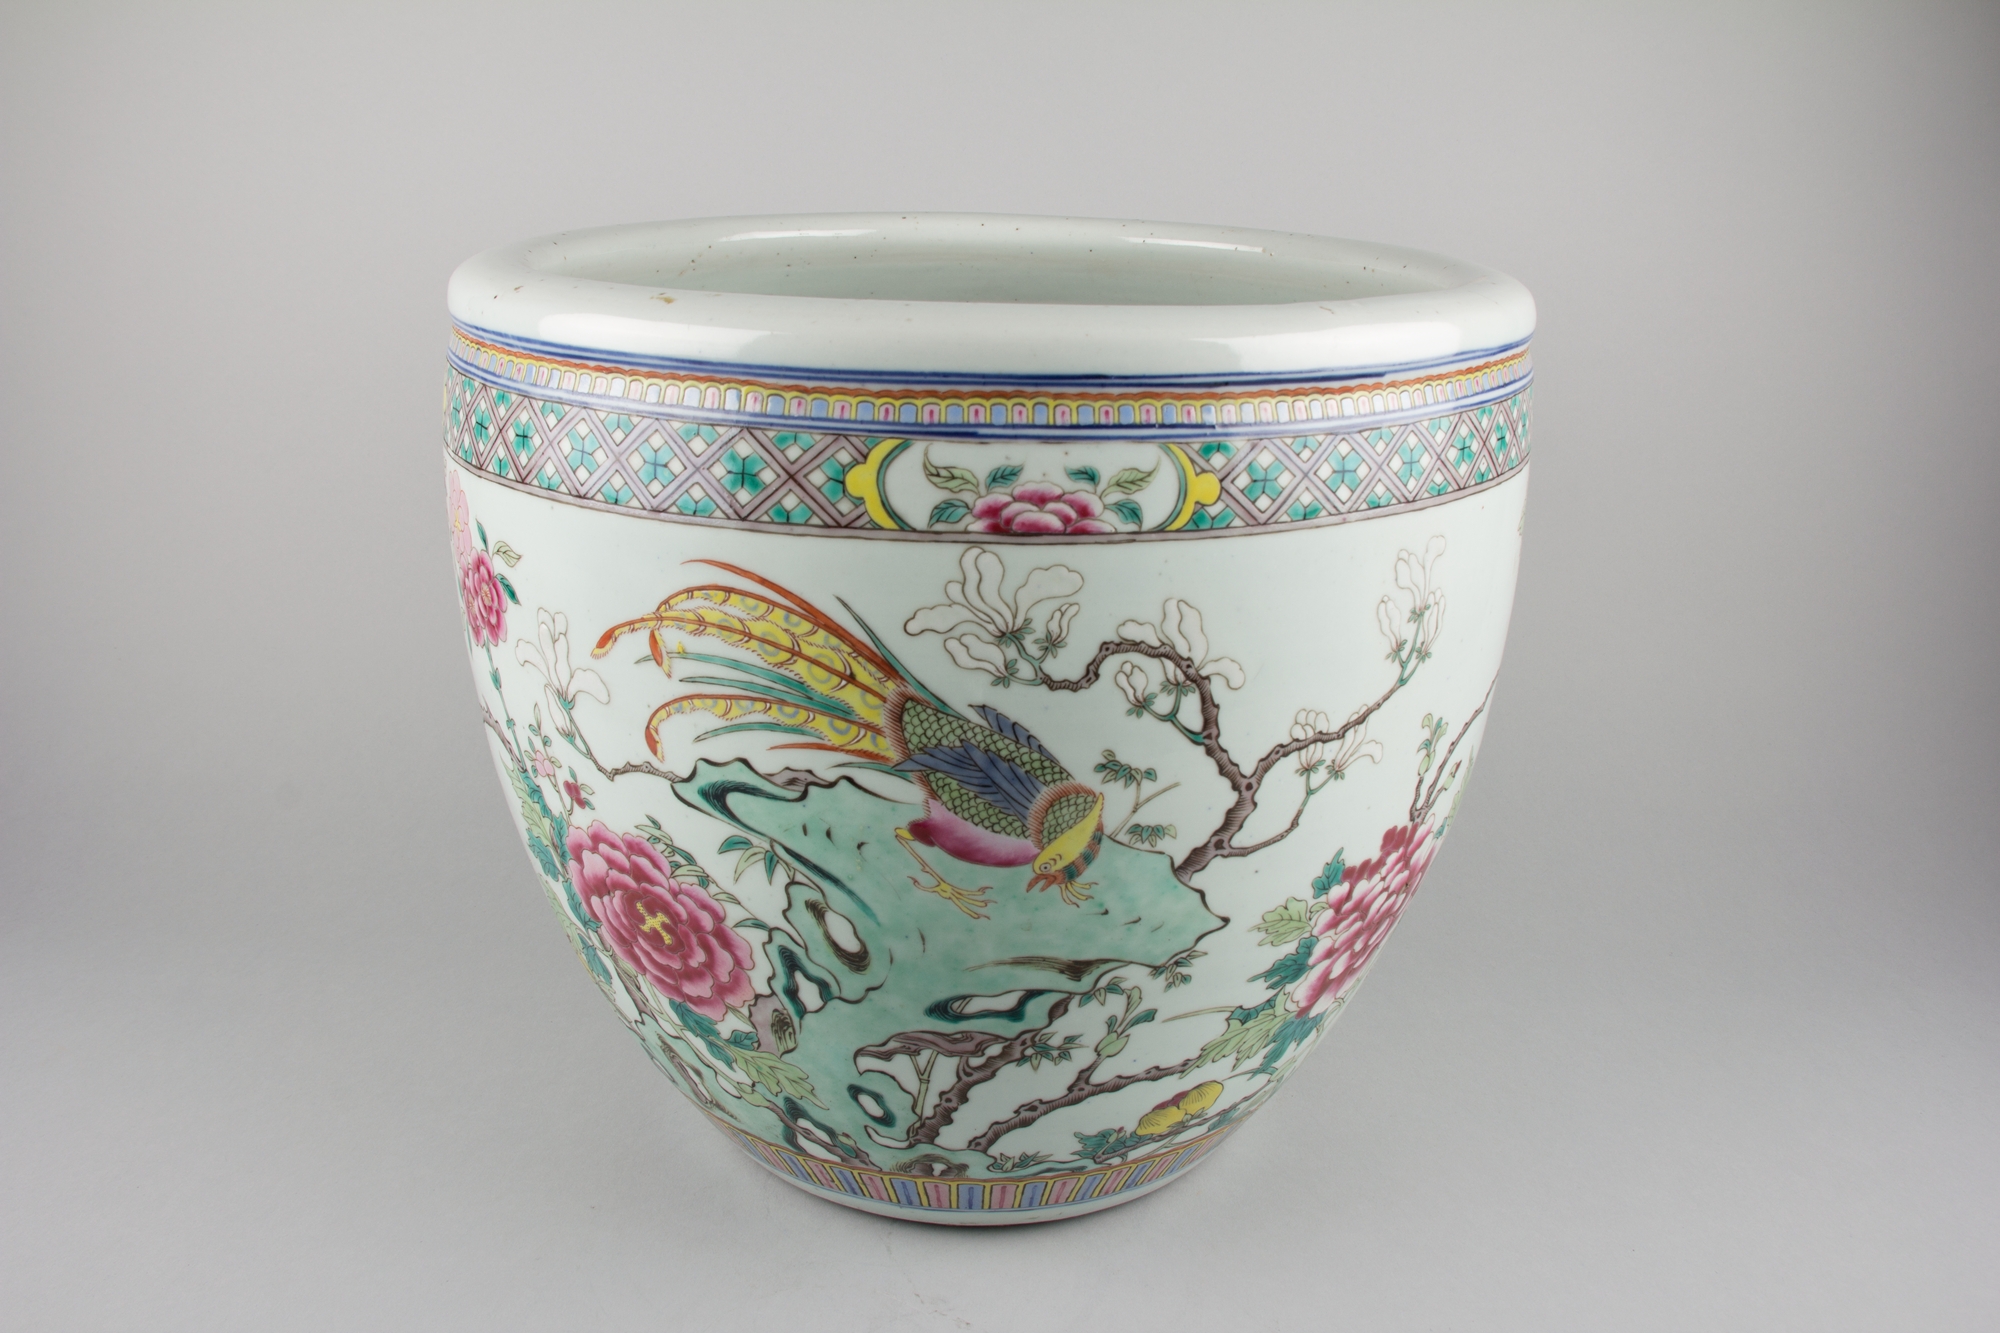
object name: fishbowl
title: Fishbowl with birds and flowers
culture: chinese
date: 1901-2000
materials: enamel, porcelain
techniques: overglaze, painting, polychrome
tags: birds,butterflies,flowers